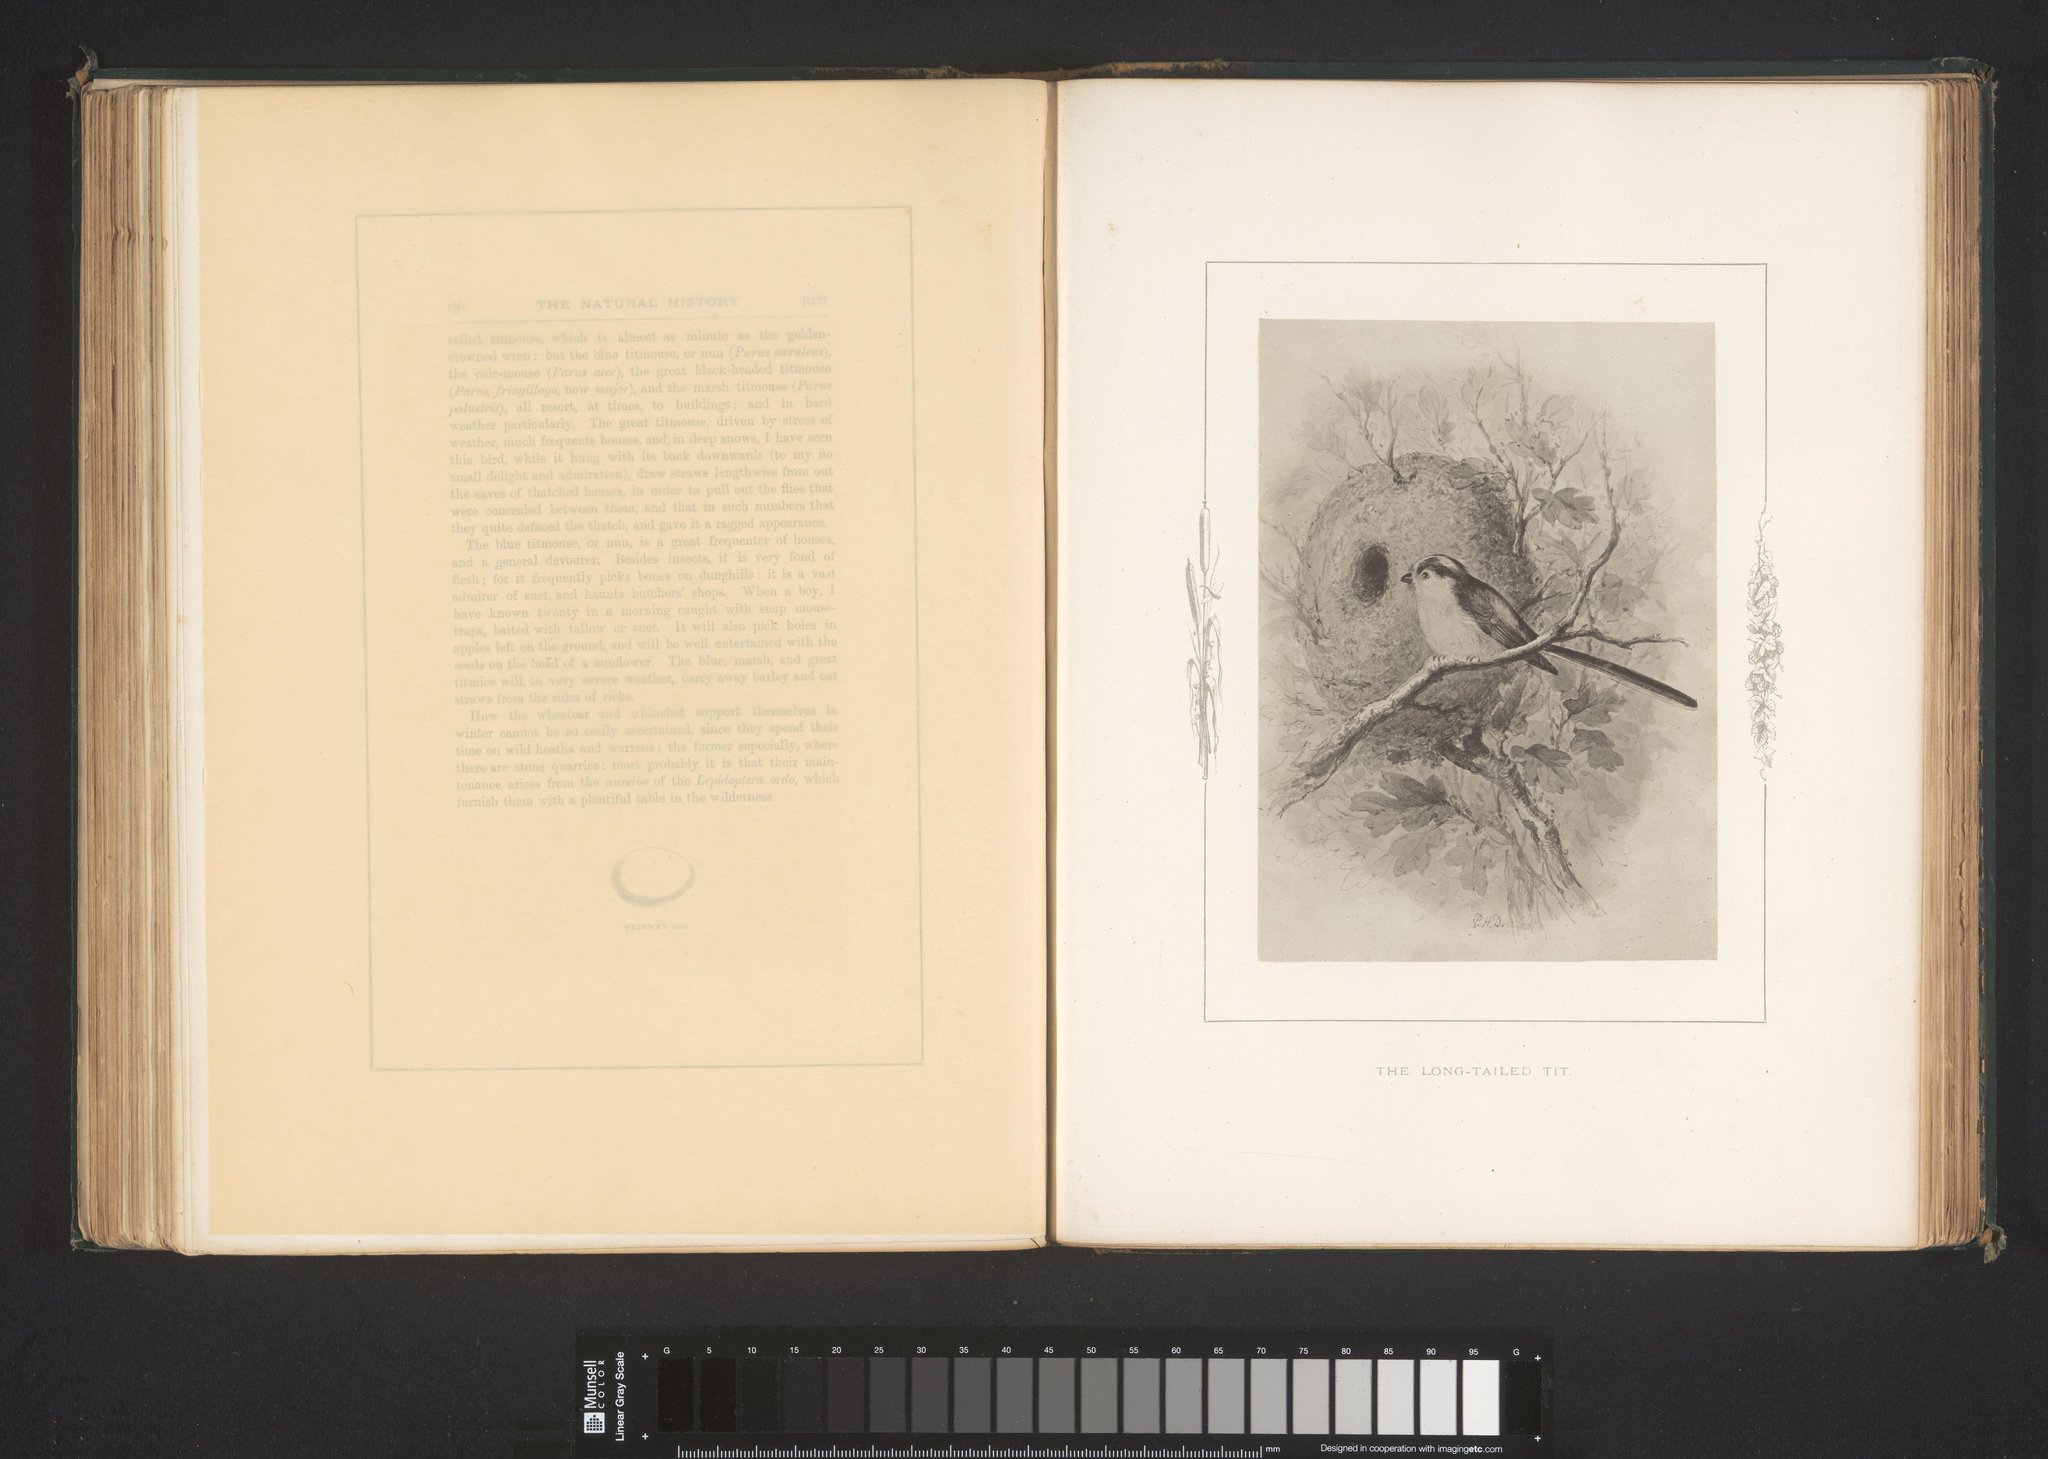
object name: page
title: The long-tailed tit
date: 1850-1876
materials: photographic support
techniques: carbon print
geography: selborne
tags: song-birds: tit